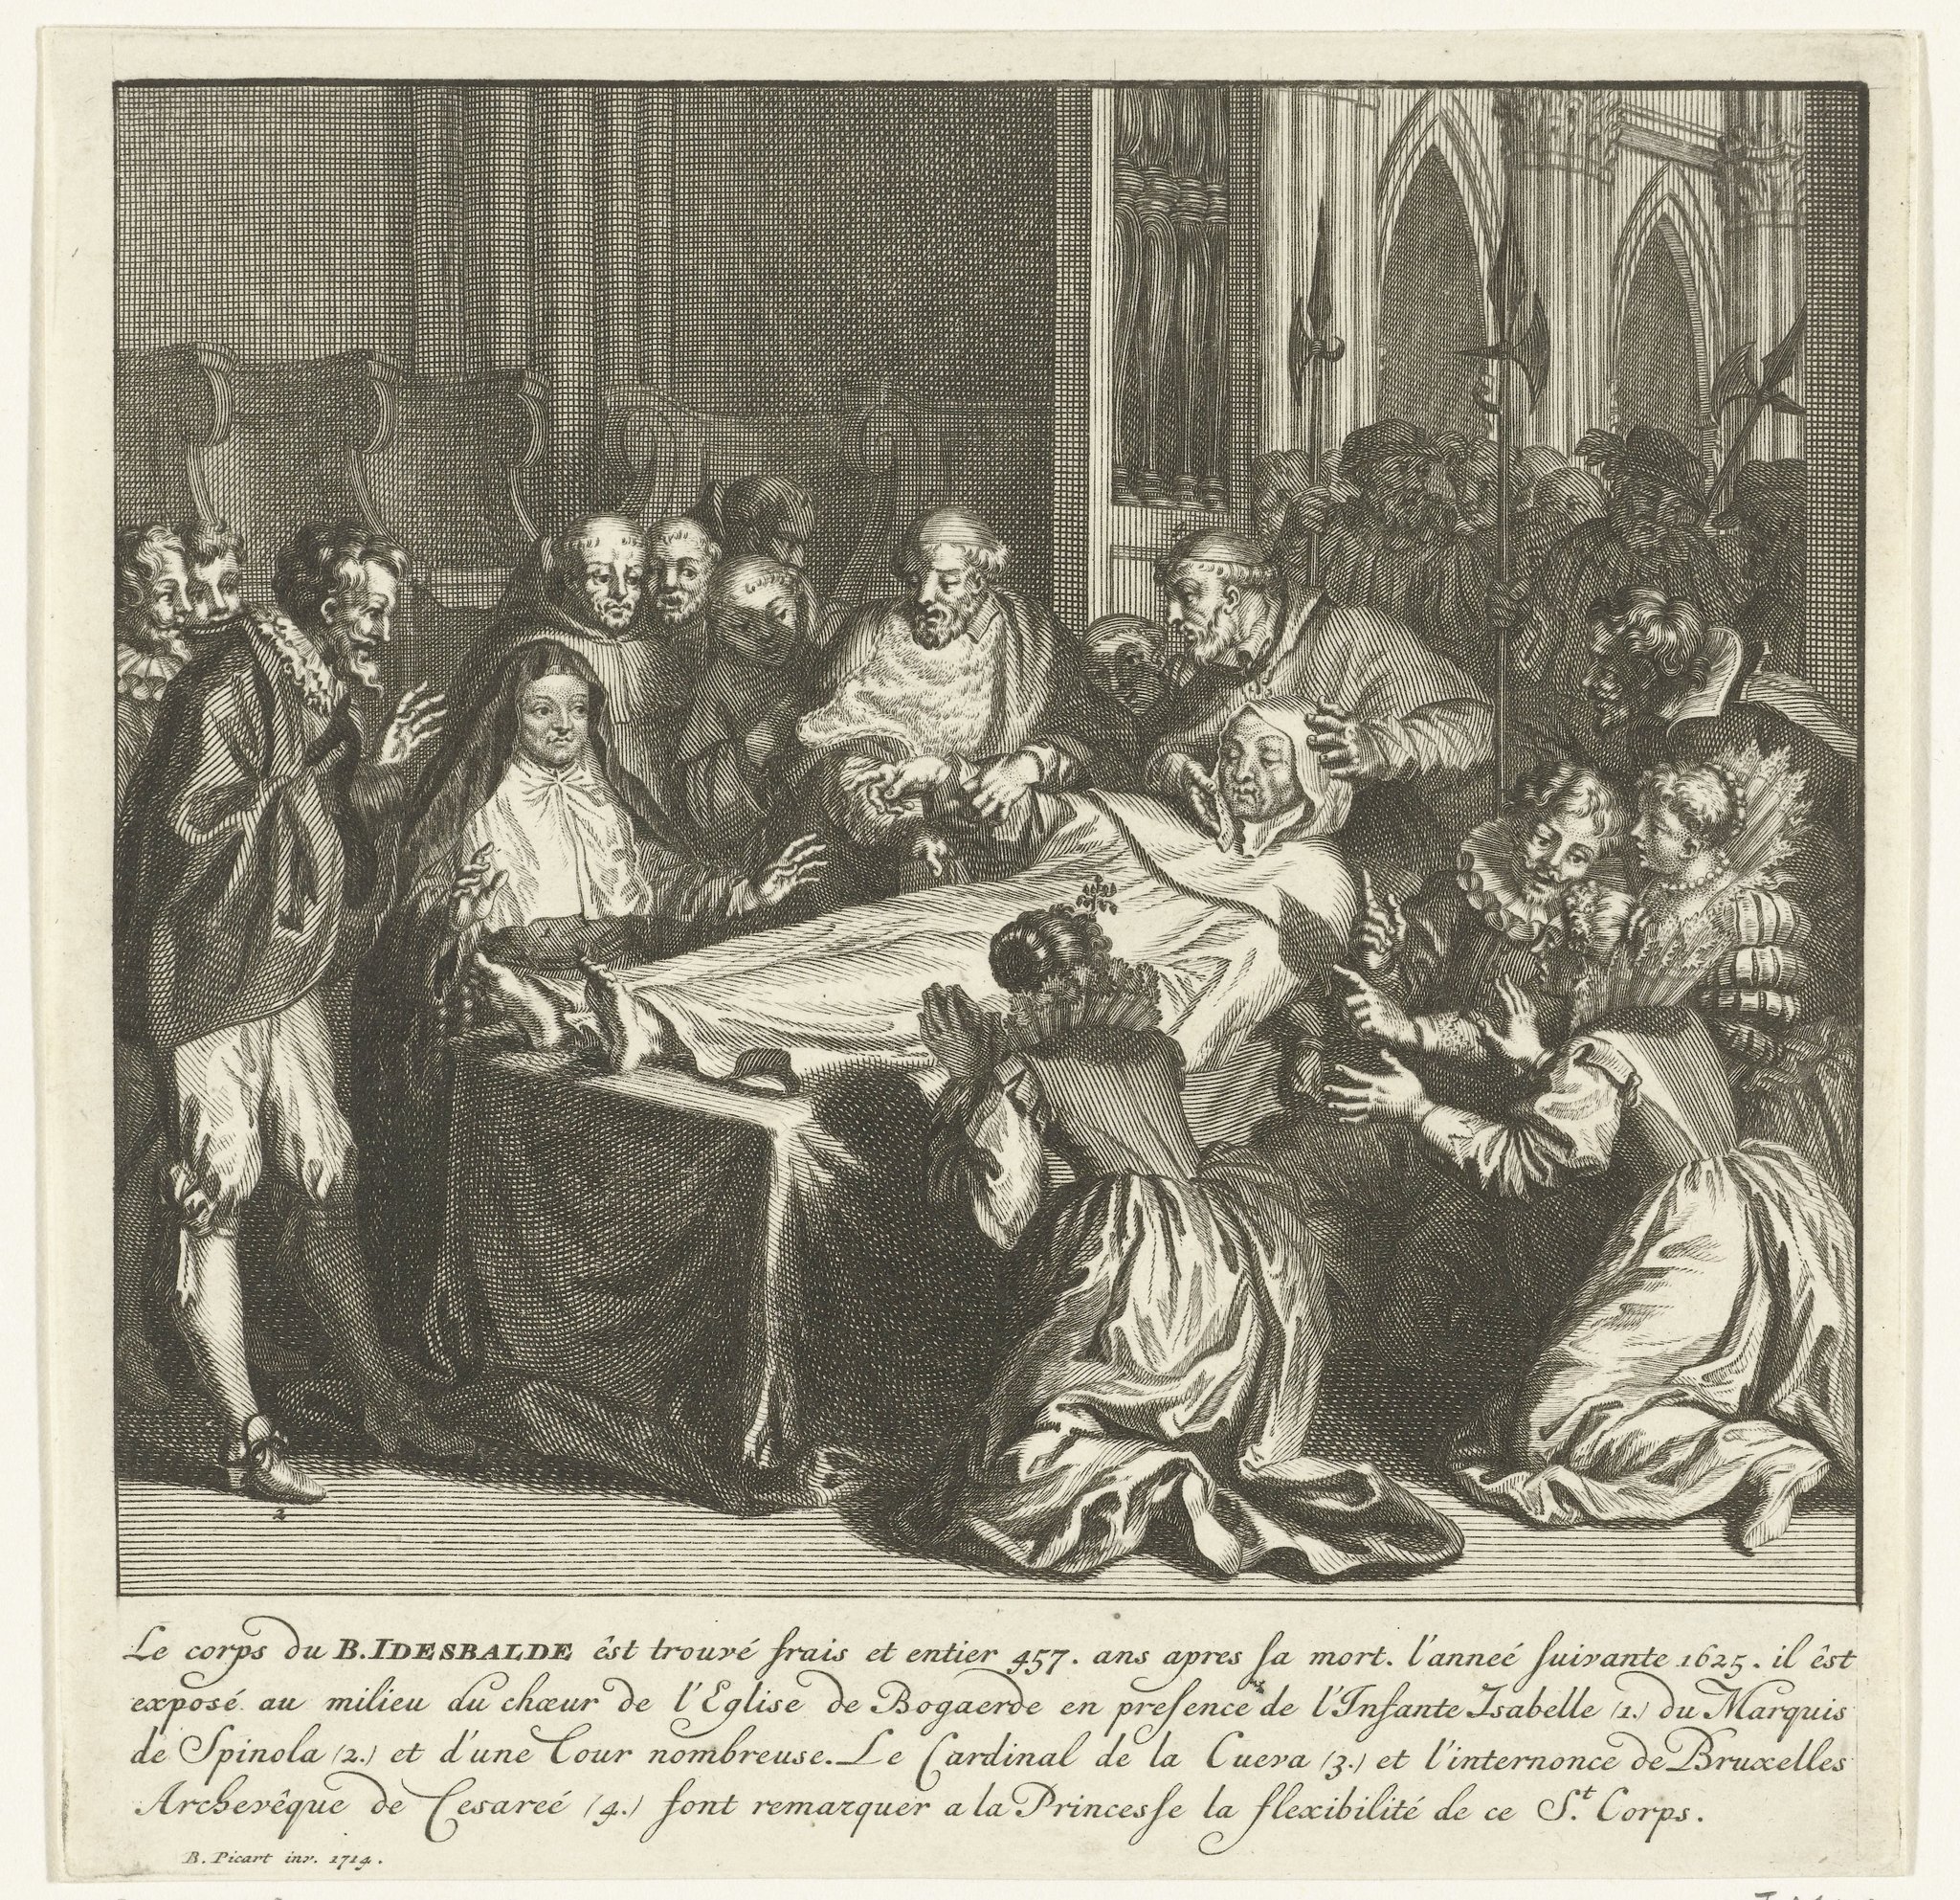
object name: print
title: Opgebaarde onverteerde lichaam van de H. Idesbald, 1625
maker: bernard picart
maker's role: draughtsman, print maker, publisher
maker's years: 1673-1733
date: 1714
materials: paper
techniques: etching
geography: northern netherlands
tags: infante van spanje isabella clara eugenia, male saints (with name), opening of grave, exhumation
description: Het wonderbaarlijk onverteerde lichaam van de zaligverklaarde Idesbald van Ter Duinen, in 1167 begraven en in 1625 (of 13 november 1623) gevonden in de abdij van Onze-Lieve-Vrouw Ten Duinen te Koksijde en ten toon gesteld in de abdijhoeve Ten Bogaerde. Om het lichaam op een praalbed is een groep toeschouwers verzameld, waaronder Isabella Clara Eugenia en Spinola. Met onderschrift van 4 regels in het Frans.